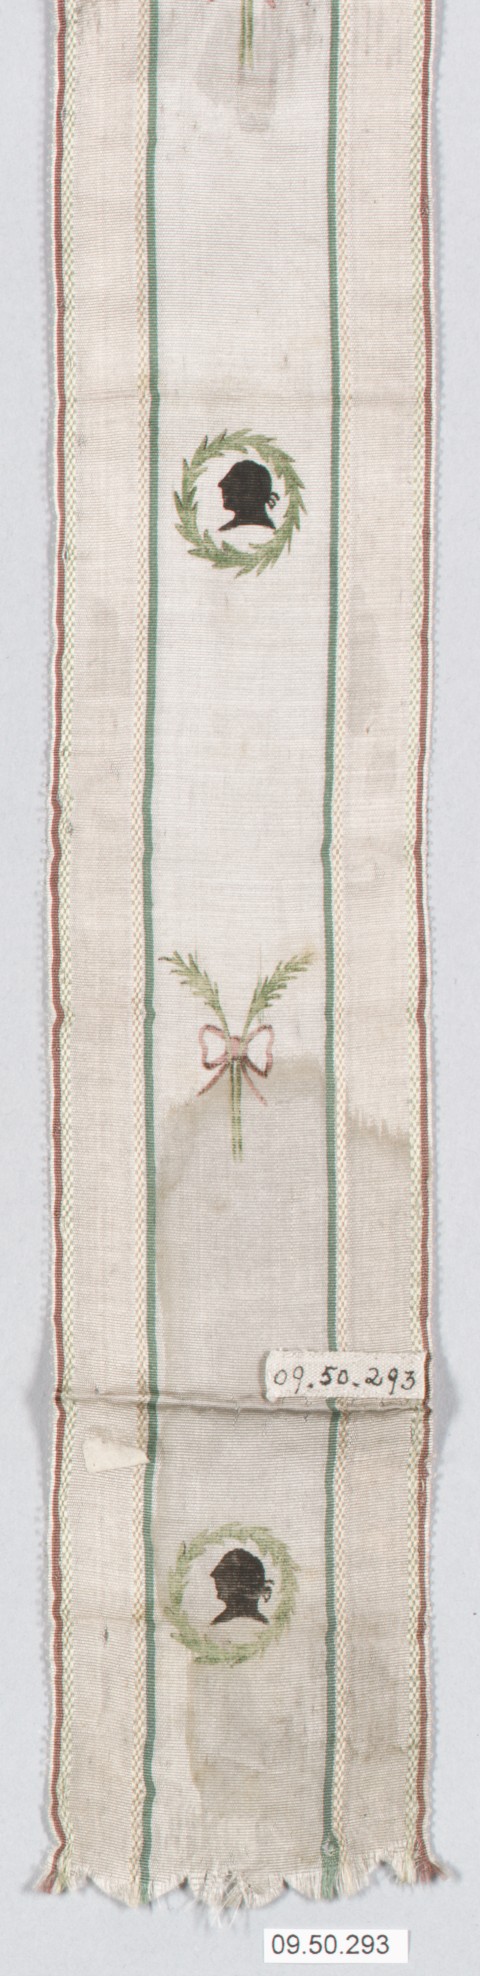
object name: ribbon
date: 1801-1833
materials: silk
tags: profiles